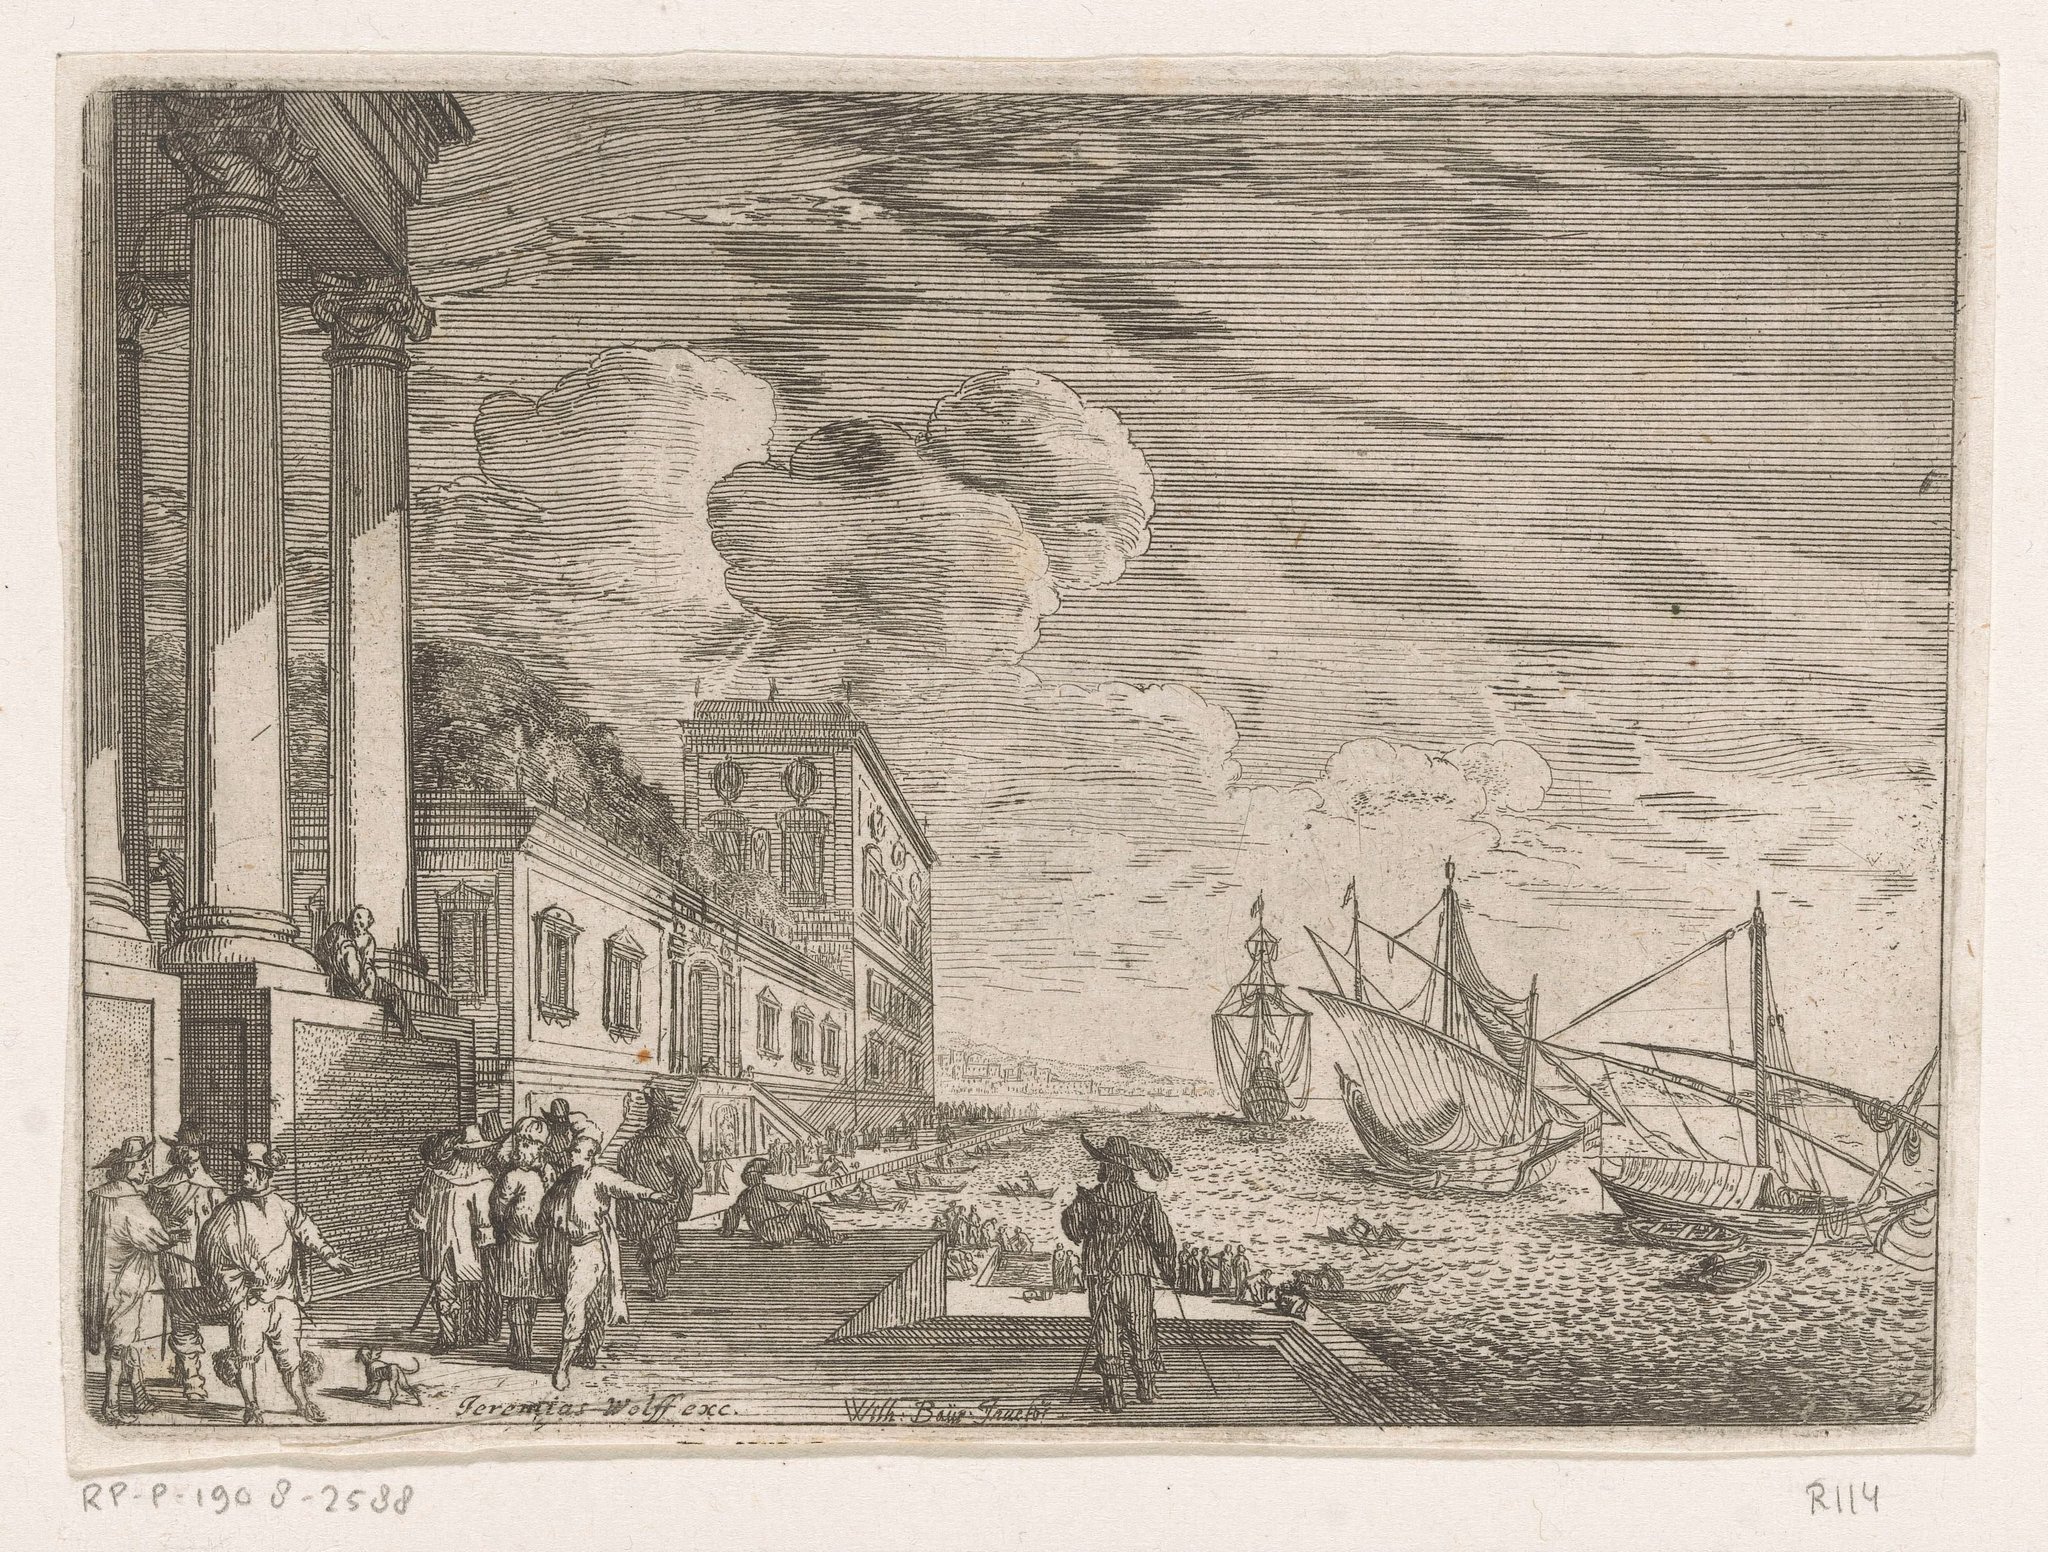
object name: print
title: Havengezichten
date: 1640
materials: paper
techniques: etching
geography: vienna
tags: harbour, sailing-ship, sailing-boat, loggia, verandah, porch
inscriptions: collector's mark: Lugt 2228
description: Prent afkomstig uit de serie 'Havengezichten', bestaand uit zeven prenten. Het betreft hier een latere druk uitgegeven door Jeremias Wolf te Augsburg.